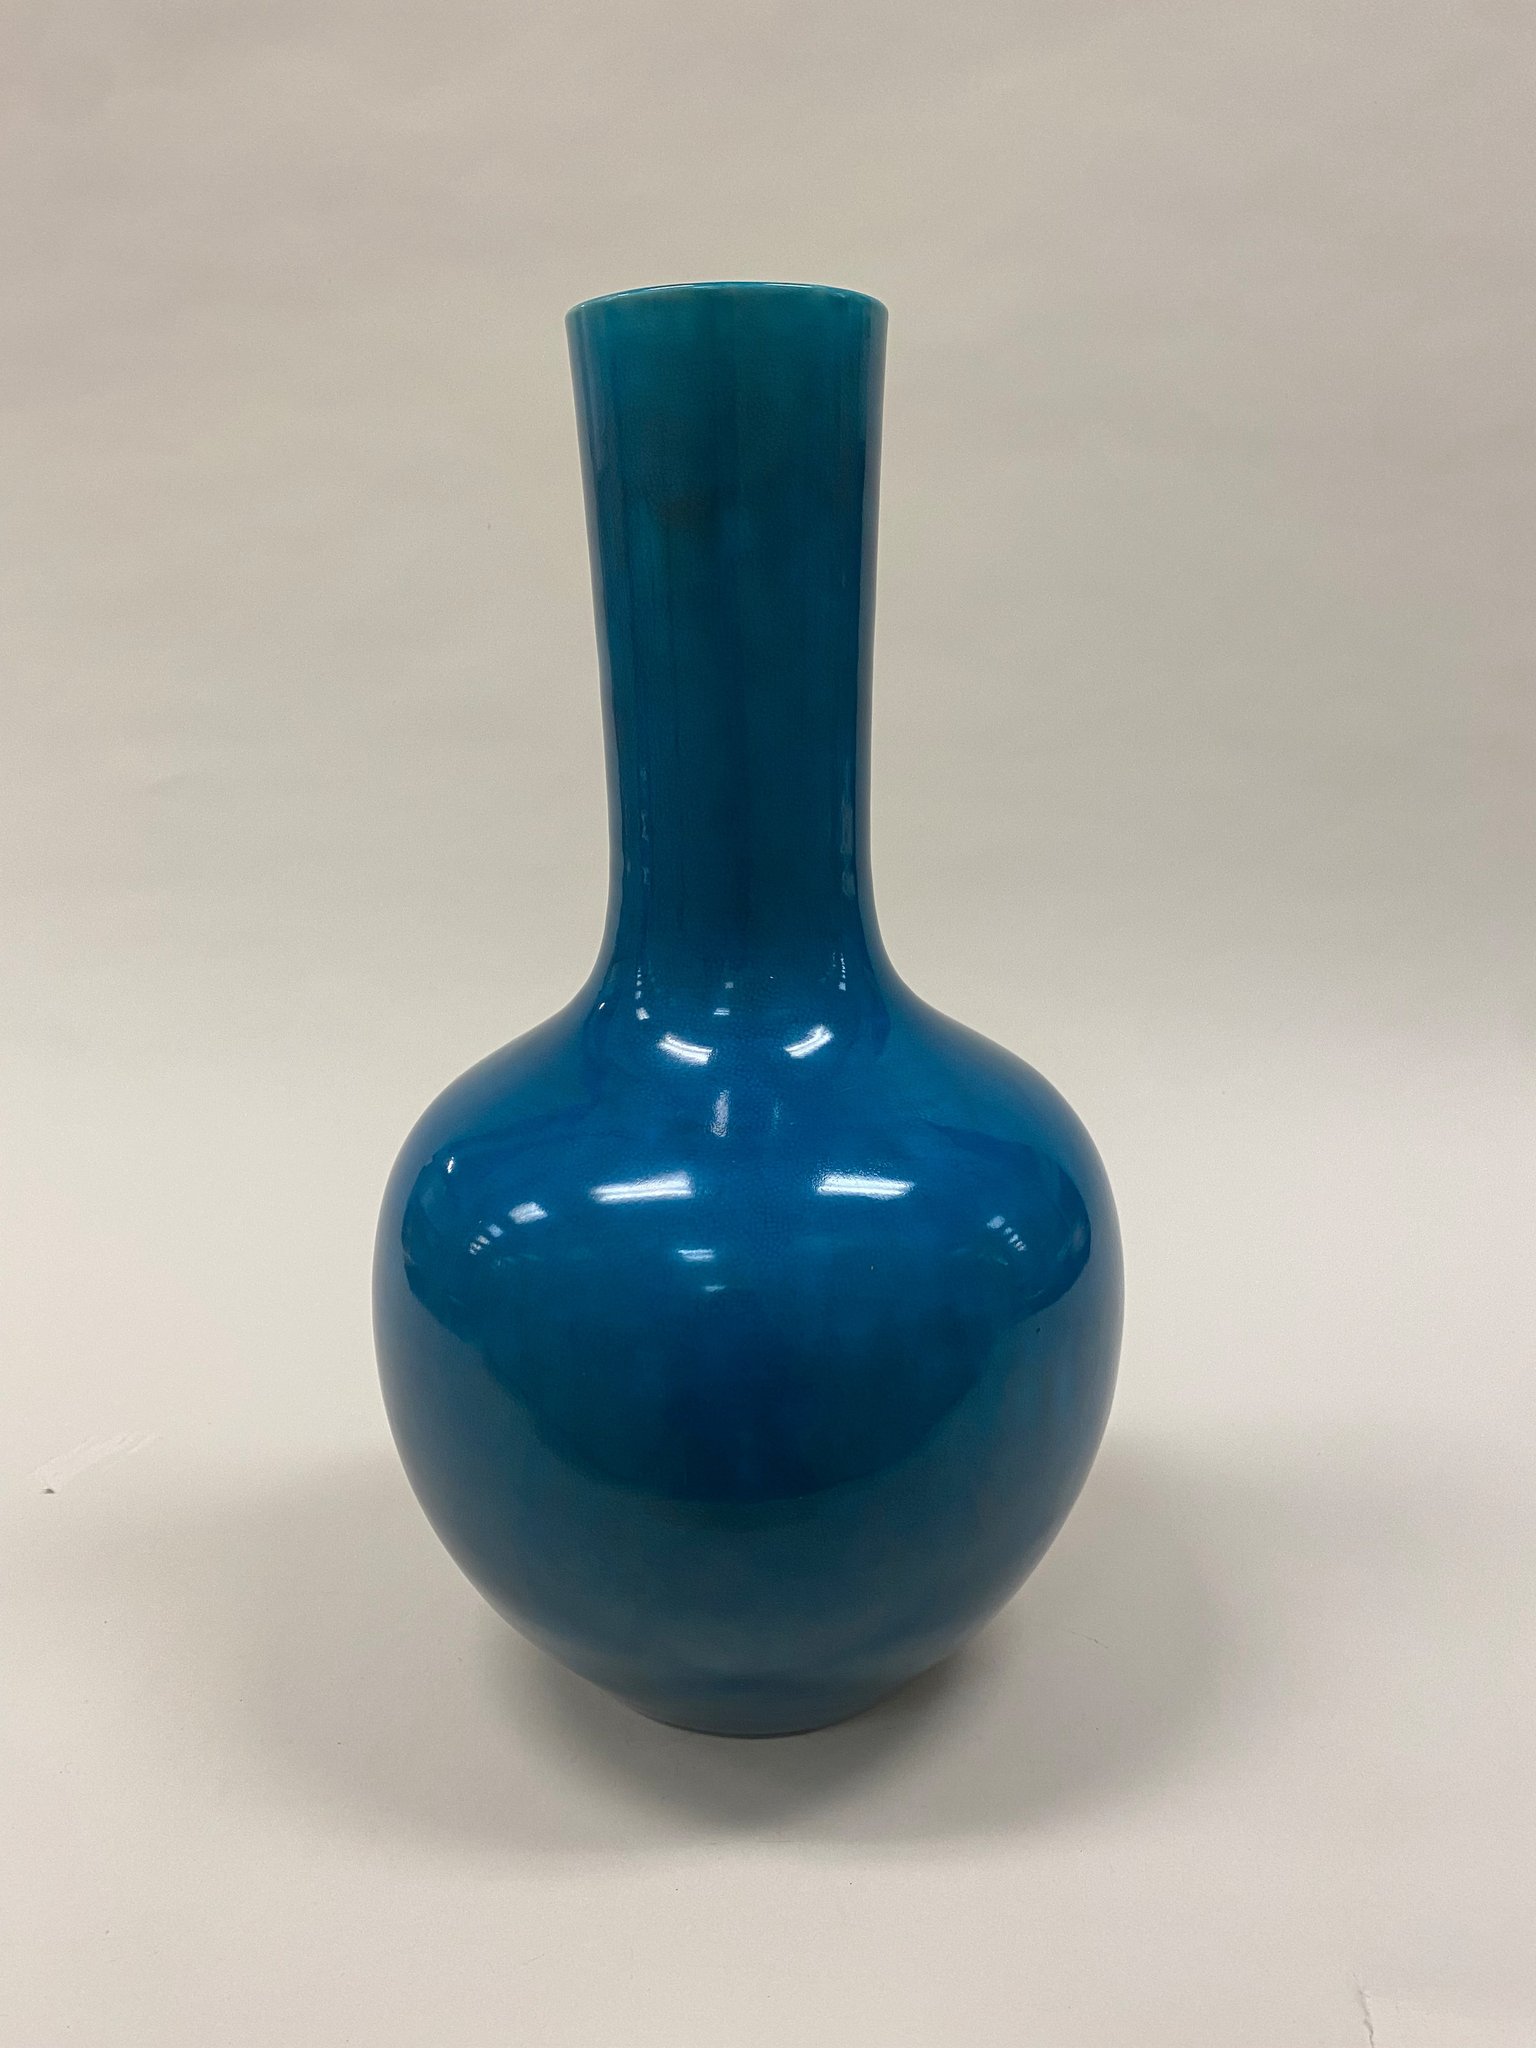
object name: vase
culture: chinese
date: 1701-1800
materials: glaze, porcelain